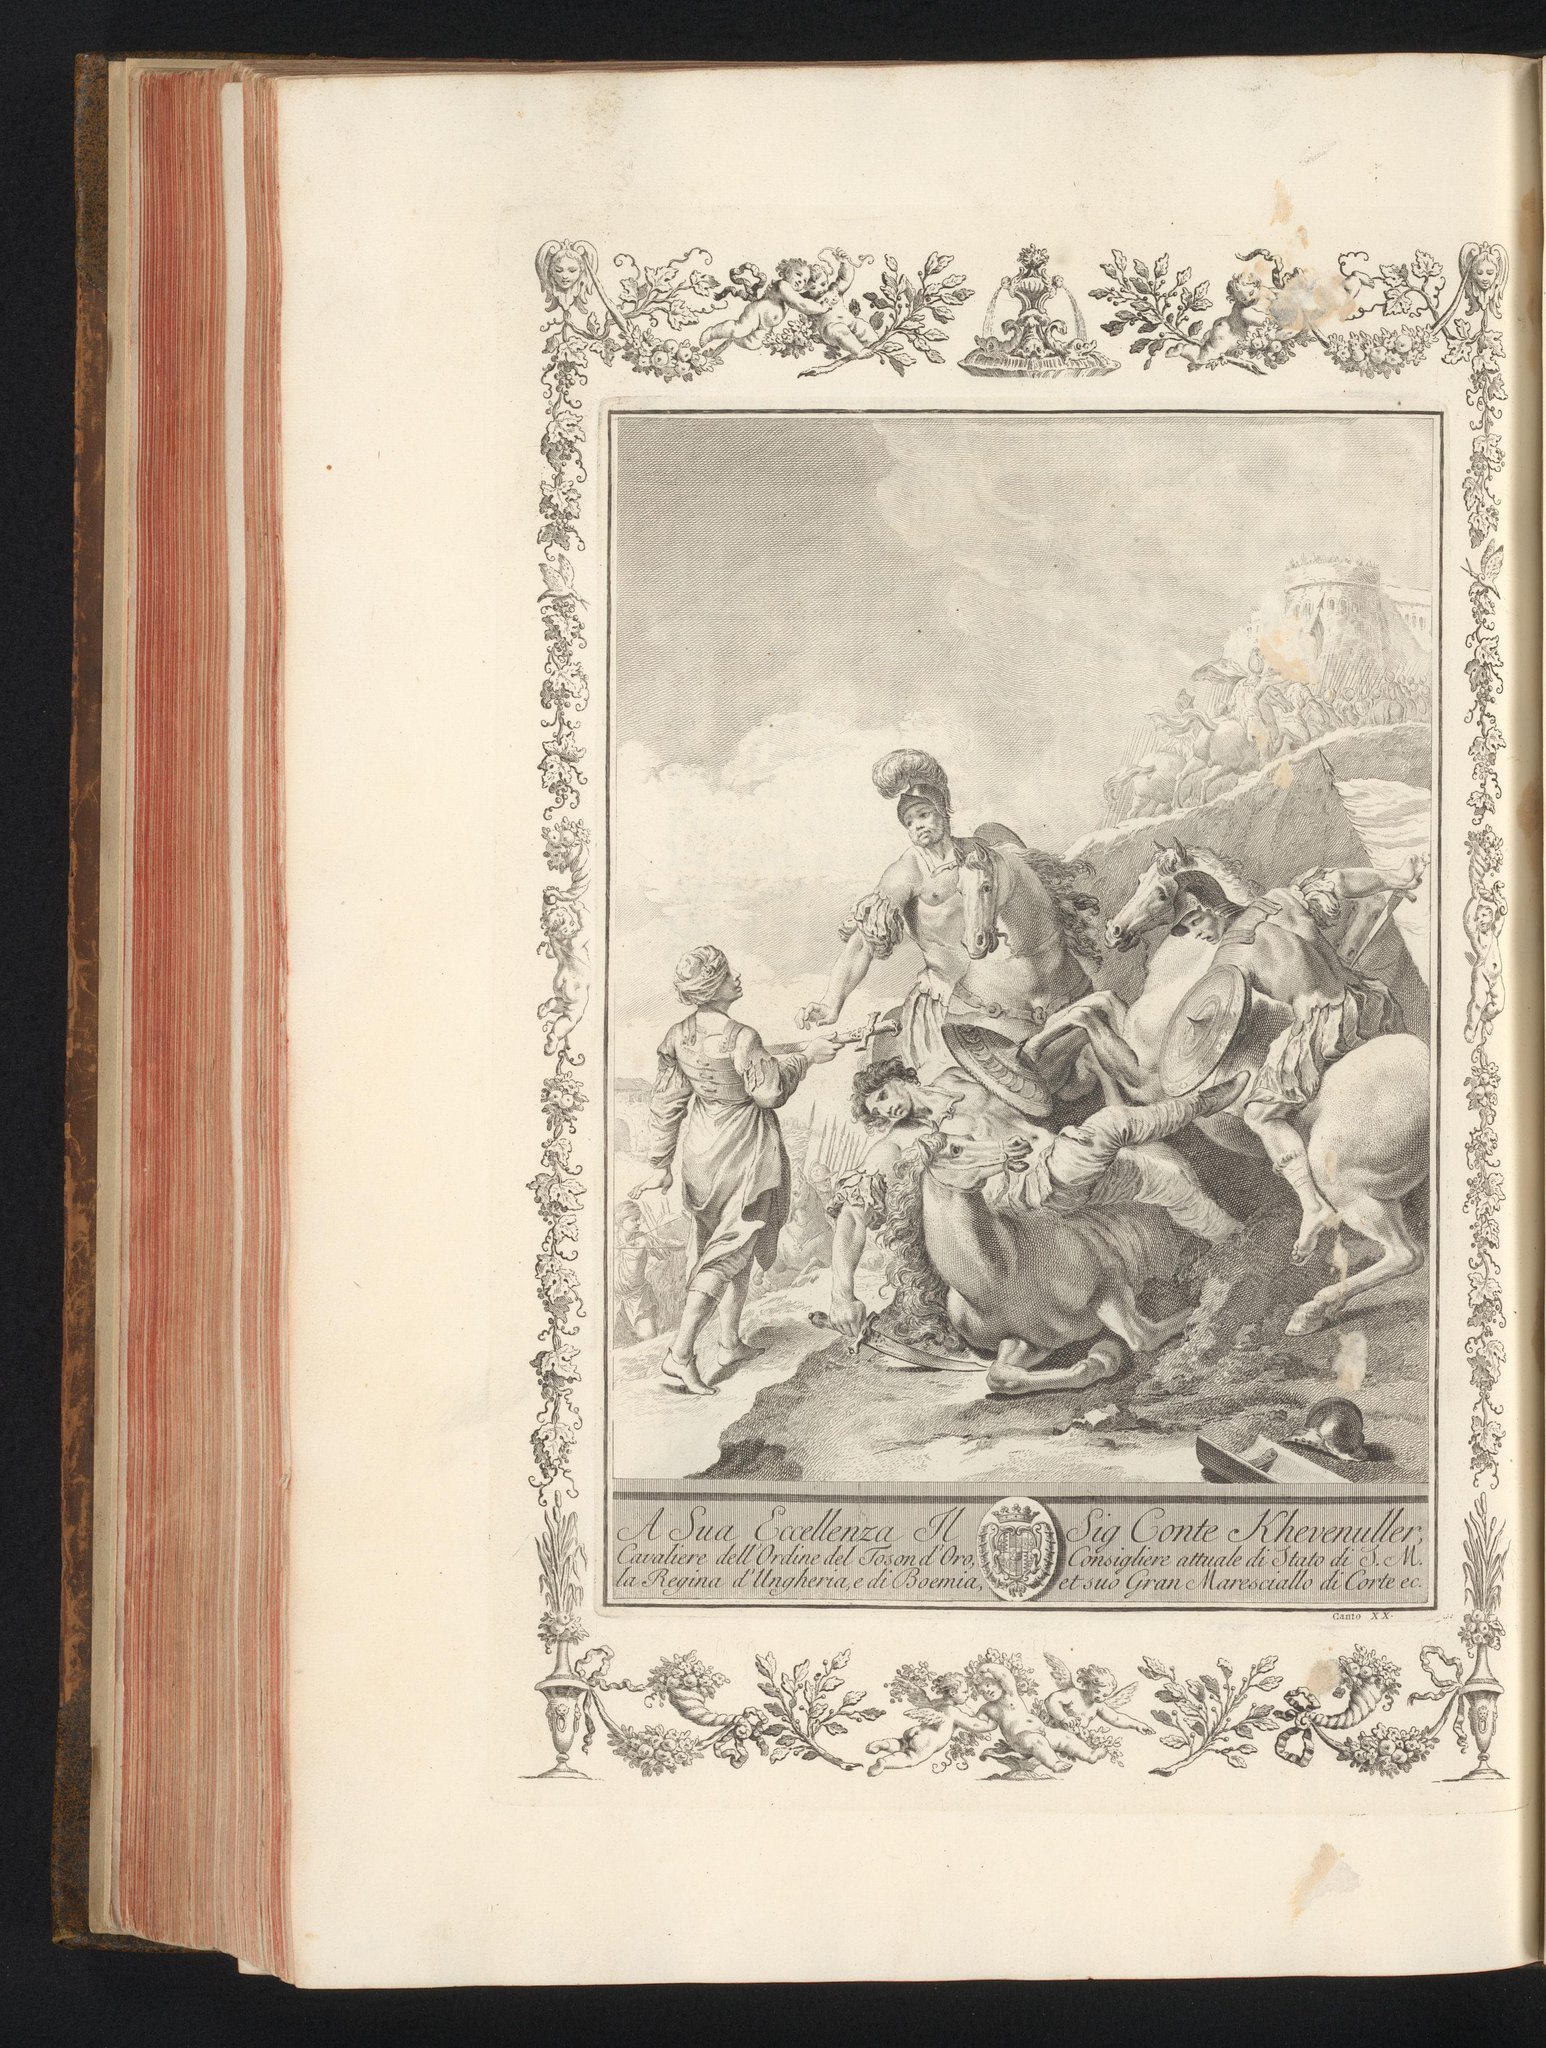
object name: book illustration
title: Soldaten te paard op een slagveld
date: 1745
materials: paper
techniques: etching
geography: venice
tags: land forces (+ during the battle), battle, (scenes from) specific works of literature: tasso, gerusalemme liberata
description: Prent uit: Tasso, Torquato. La Gerusalemme liberata di Torquato Tasso con le figure de Giambatista Piazzetta. Venetië: Giambatista Albrizzi, 1745.